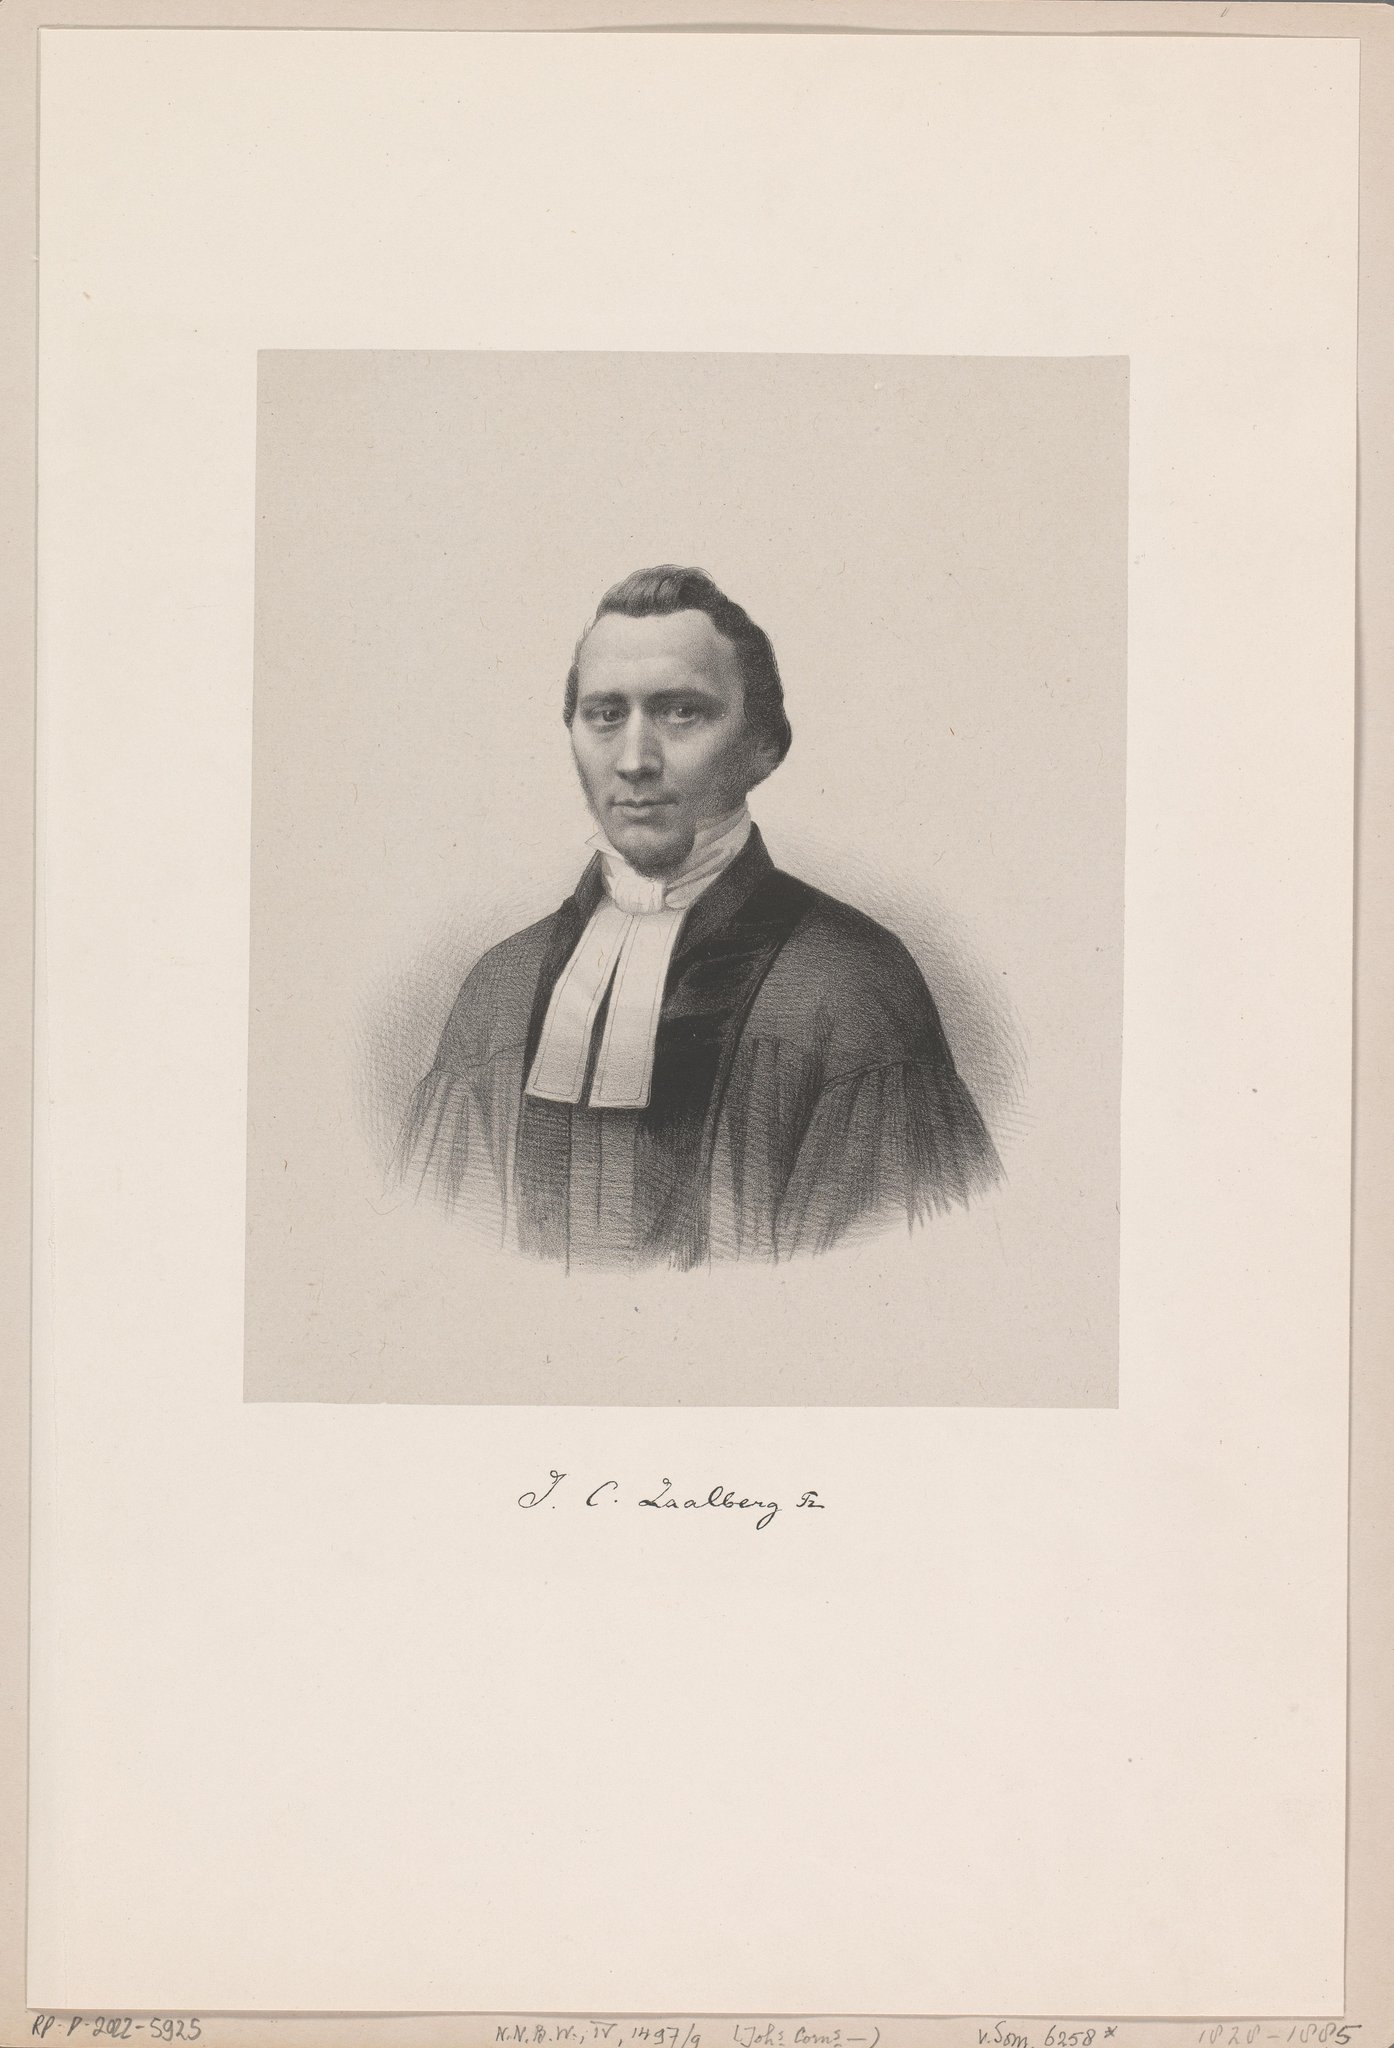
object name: print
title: Portret van Johannes Cornelis Zaalberg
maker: Anonymous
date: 1848-1885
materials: paper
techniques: lithograph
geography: netherlands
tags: historical persons, functionaries and dignitaries ~ protestant churches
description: Met facsimile handtekening van geportretteerde.